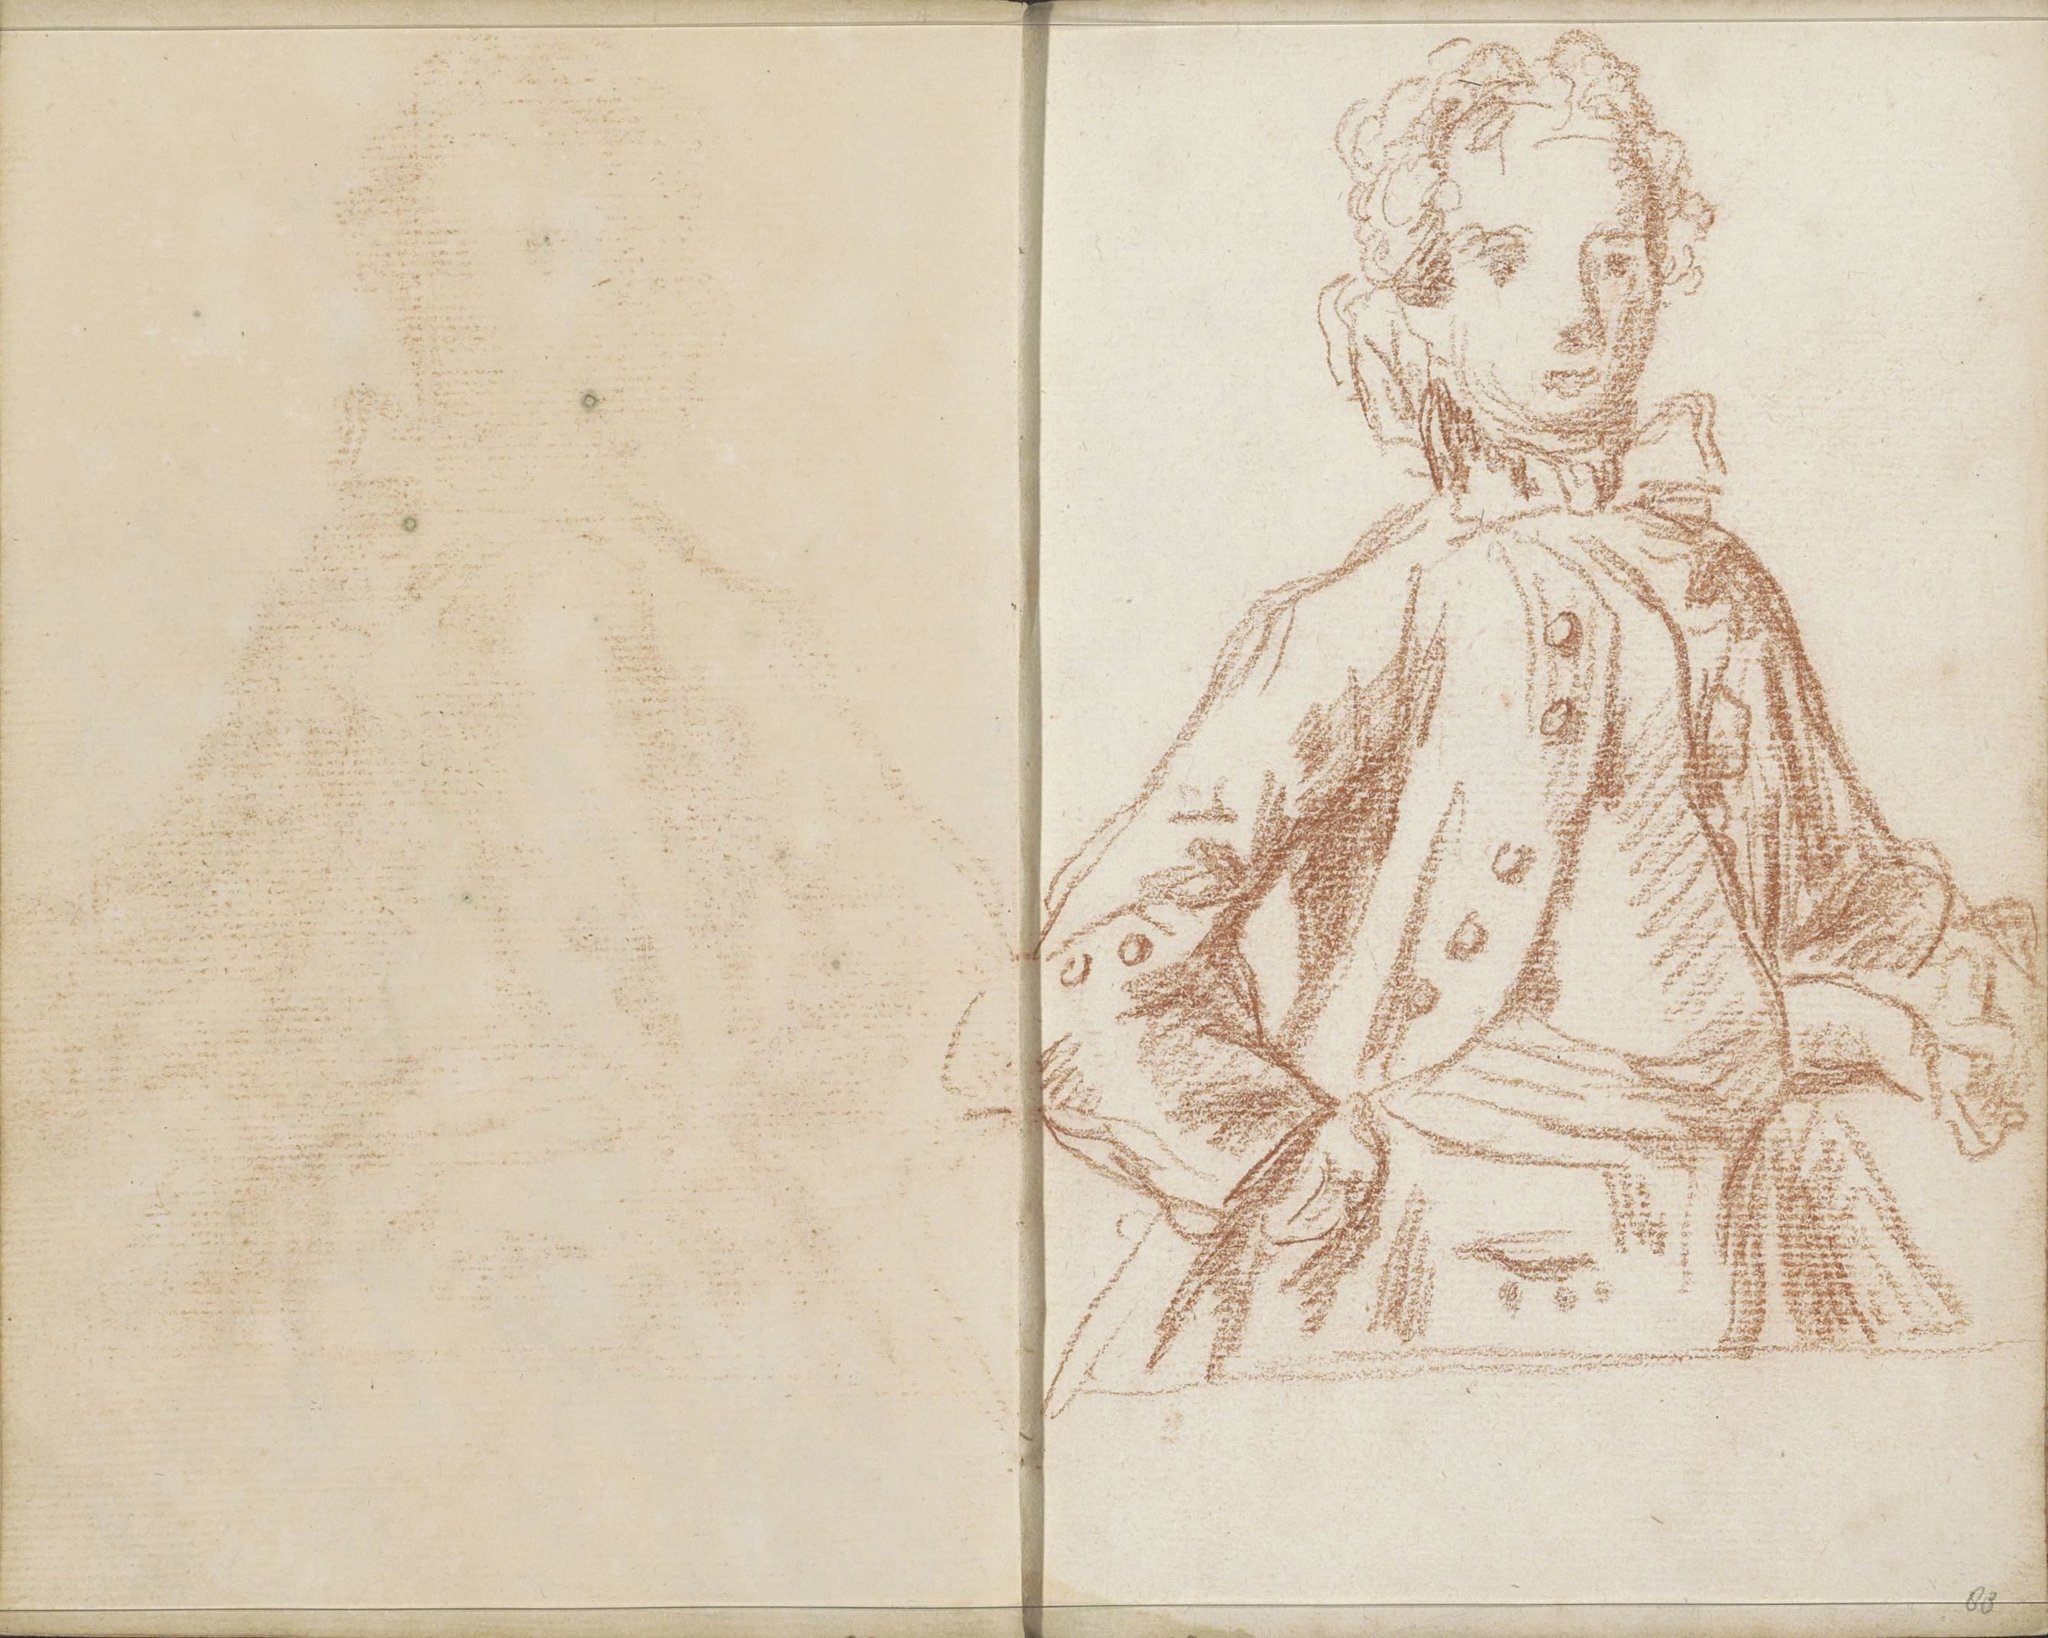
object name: sketchbook leaf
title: Portret van een jongeman met de hand op de heup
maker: petrus johannes van reysschoot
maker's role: draughtsman, print maker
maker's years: 1702-1772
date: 1710-1772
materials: chalk, paper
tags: hand on the hip, anonymous historical person portrayed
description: Blad 82 verso en 83 recto uit een schetsboek met 105 bladen.